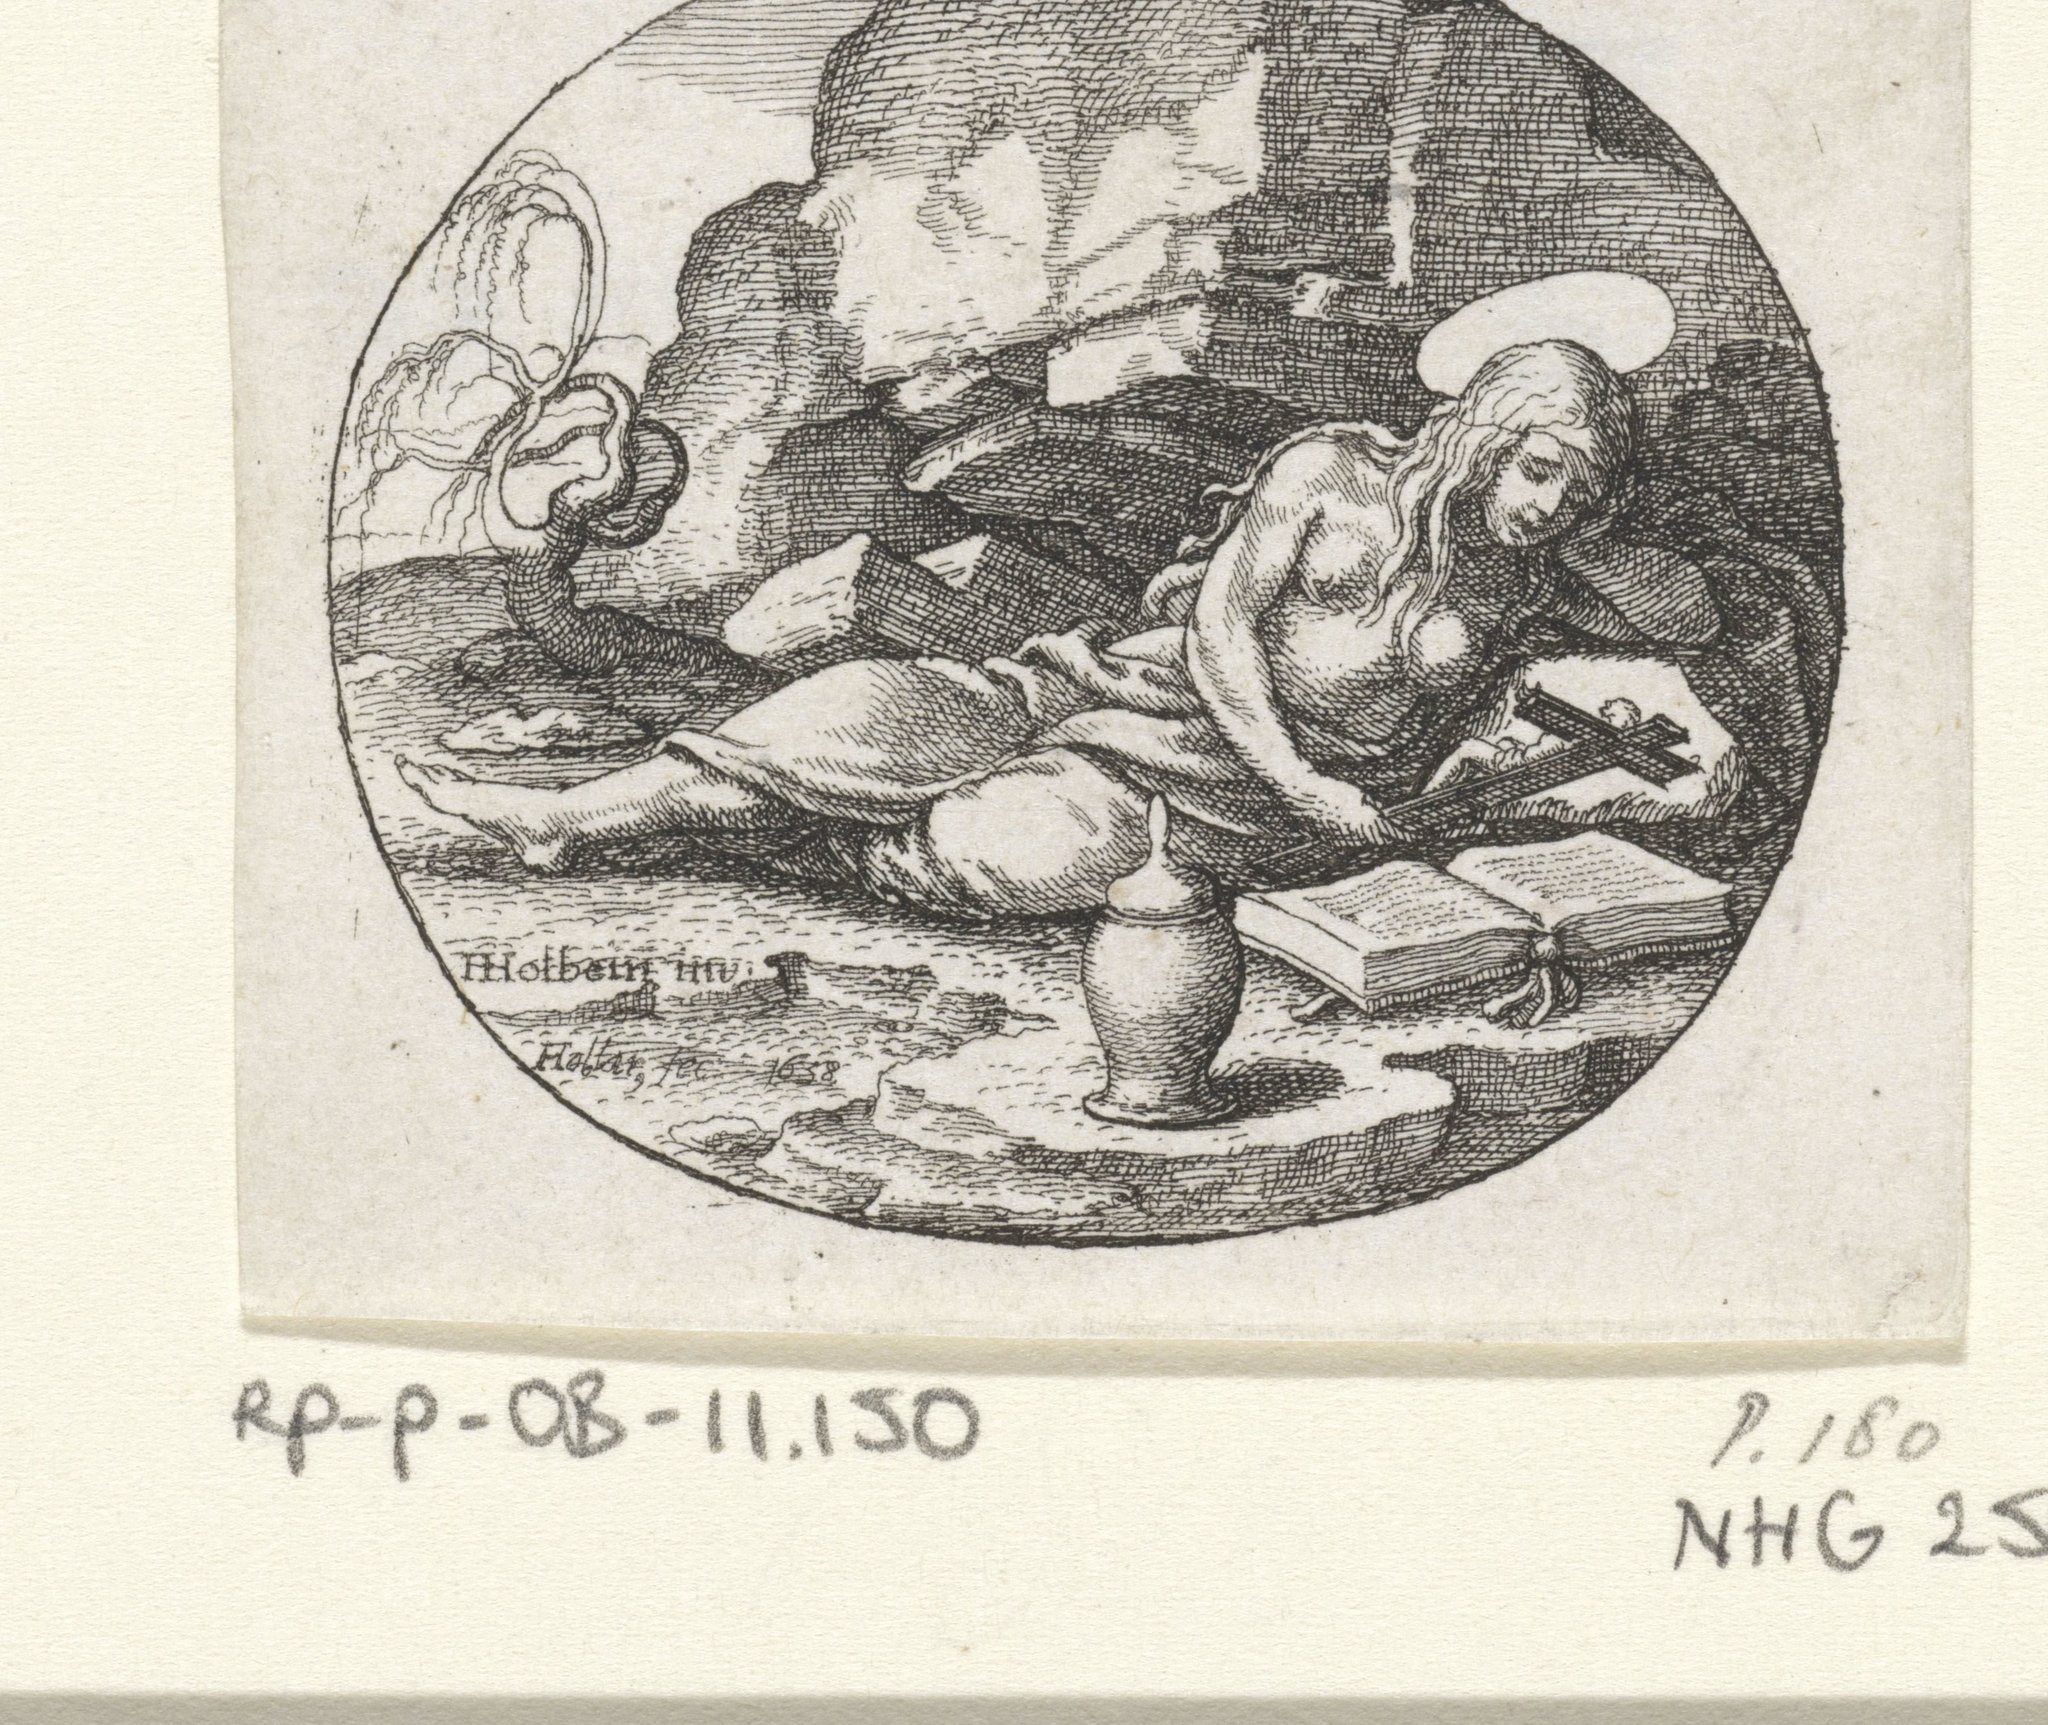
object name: print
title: De boetvaardige Maria Magdalena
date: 1638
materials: paper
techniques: etching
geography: london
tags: the penitent st. mary magdalene (often before a cave, possibly at la sainte-baume hill): her long hair covers her (naked) body, she reads, meditates or raises her tear-filled eyes towards heaven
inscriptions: collector's mark: Lugt 240